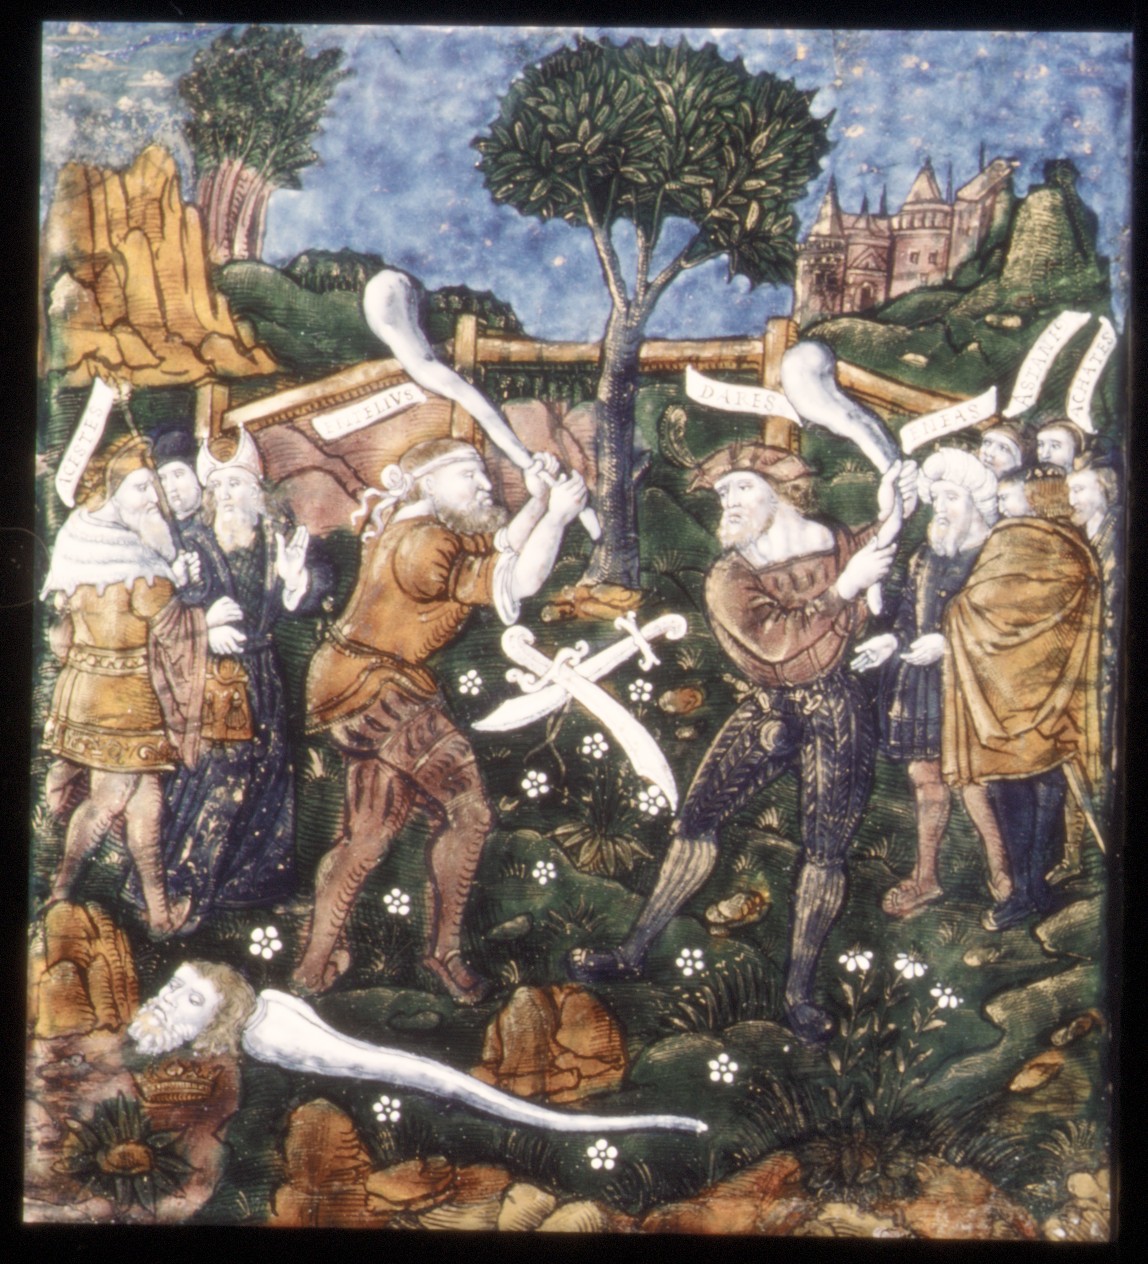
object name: plaque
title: The Combat between Dares and Entellus (Aeneid, Book V)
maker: master of the aeneid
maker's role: artist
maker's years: 1525-1545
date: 1530-1535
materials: copper, enamel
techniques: gilding, painting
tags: battles,men